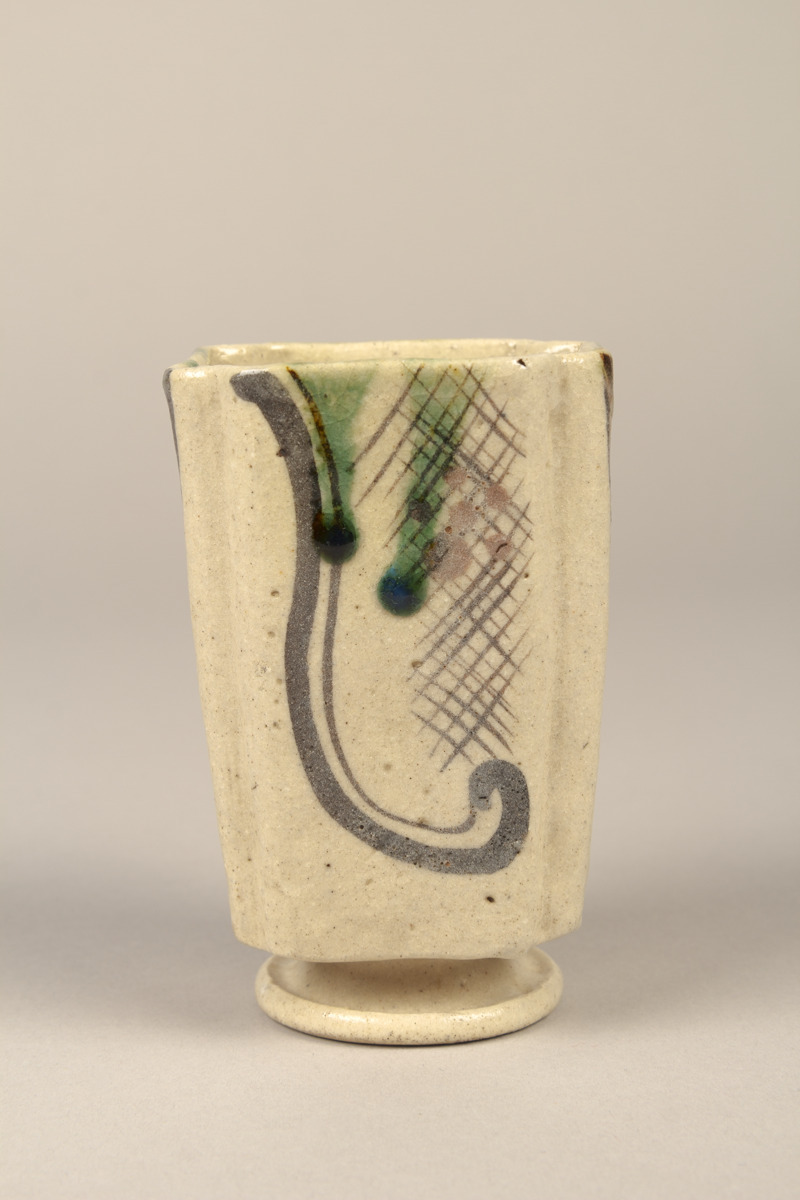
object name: food vessel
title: One from set of five squared food vessels (mukōzuke) for tea-gathering meal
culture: japanese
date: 1601-1633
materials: copper, iron, stoneware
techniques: overglaze